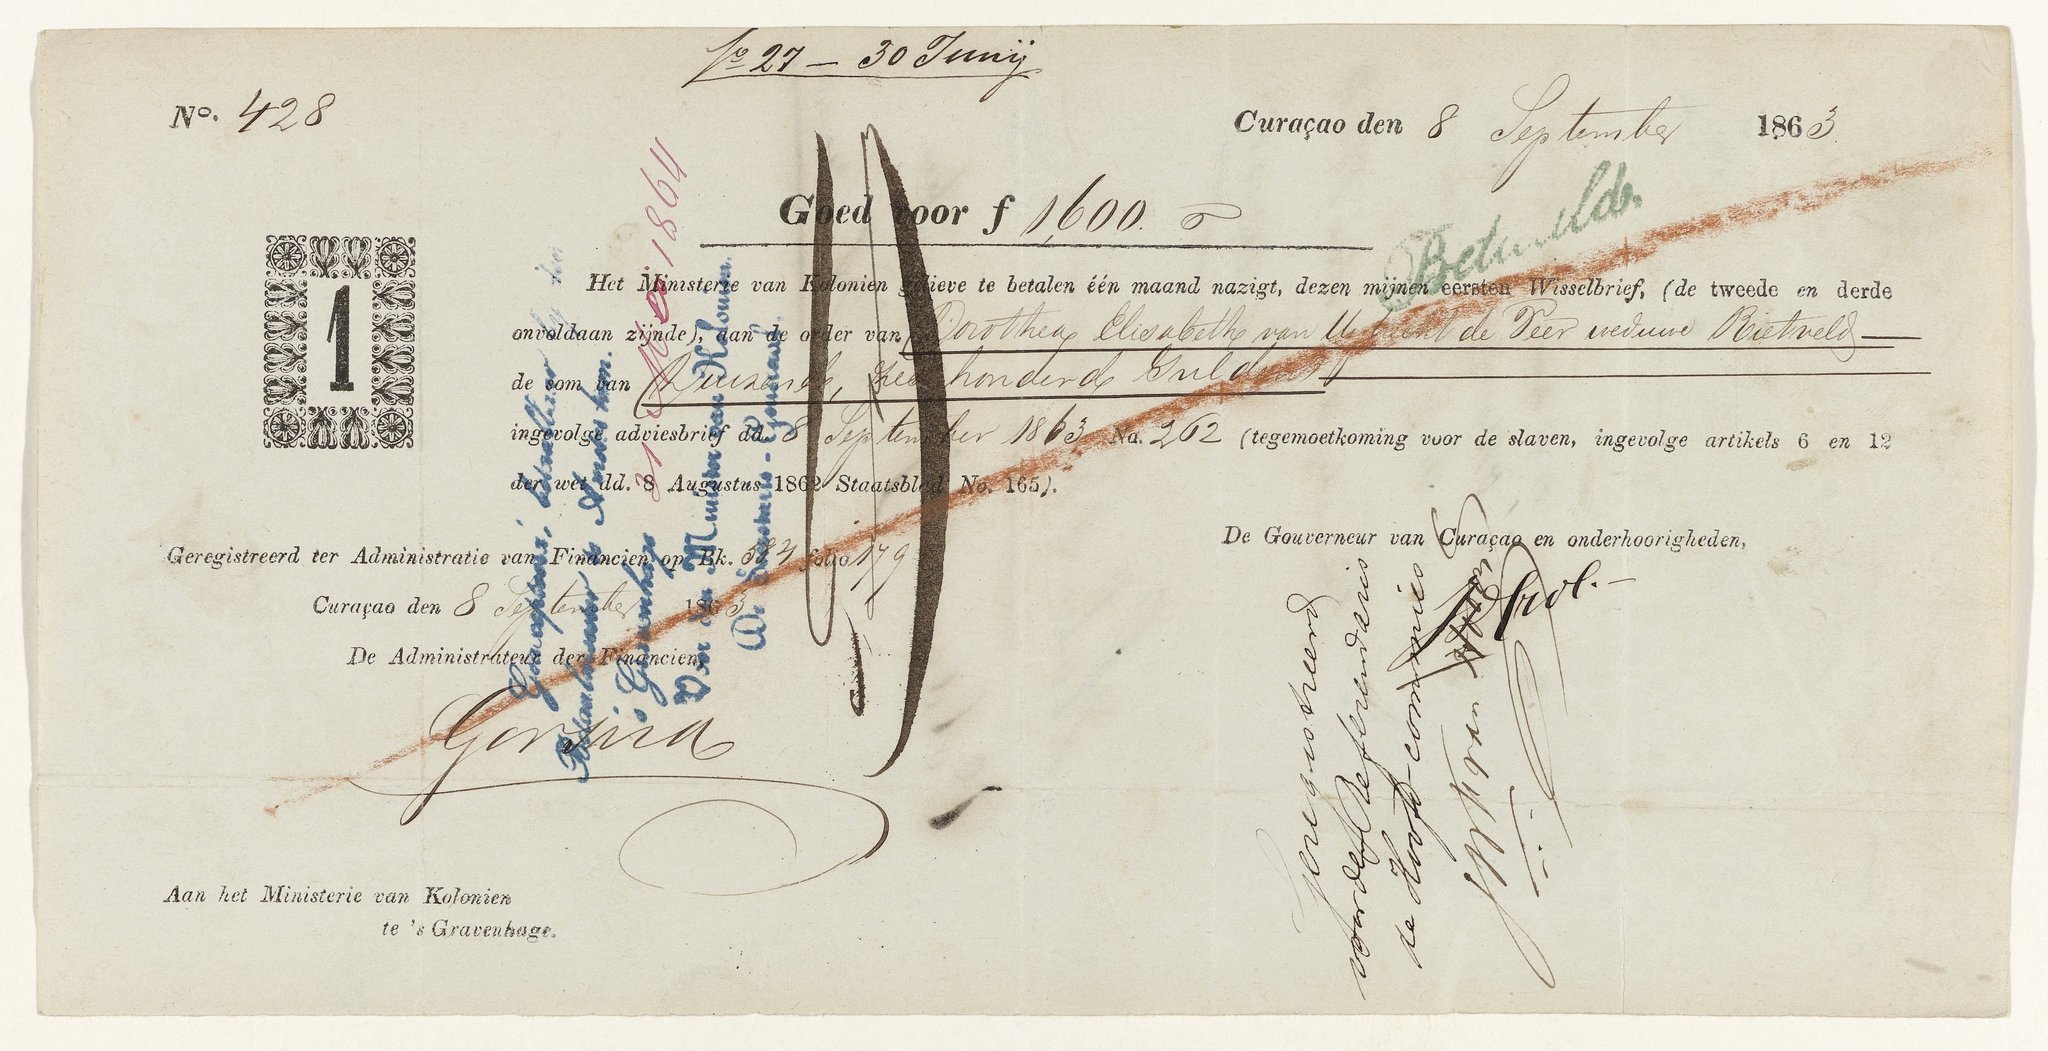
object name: letter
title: Bill of Exchange ‘Abolition of Slavery’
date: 1863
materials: paper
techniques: printing, writing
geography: the hague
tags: slavery; serfs and enslaved persons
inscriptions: date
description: Slavery was abolished in Suriname and the Dutch Antilles in 1863. Dorothea Elisabeth van Uytrecht de Veer received 1600 guilders for the eight people she had held in slavery. Bitorina Voes, Carolina los Santos Broos, Christiaan Voes, Ermij Voes, Maria Broos, Marij Kook and Victor Voeg were given their freedom in 1863, but no financial compensation.